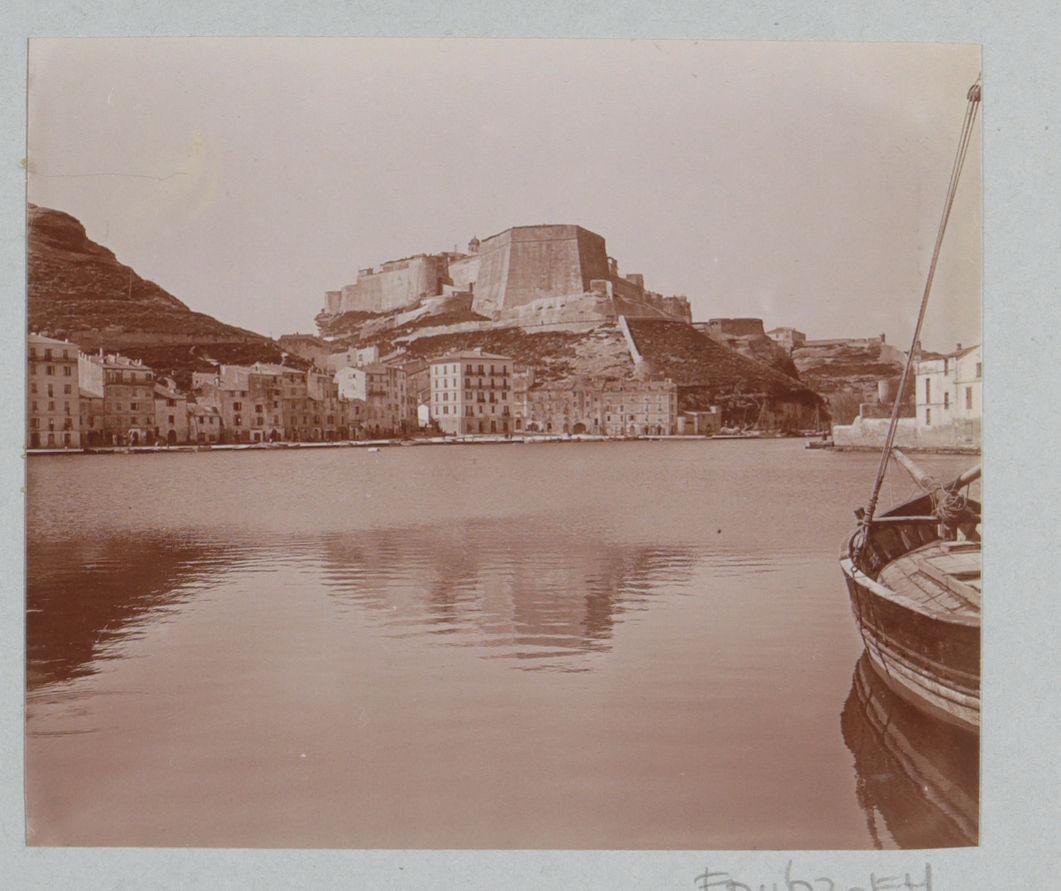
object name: photograph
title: Gezicht op Bonifacio op Corsica met haven en citadel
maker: Anonymous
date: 1905-1910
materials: paper, photographic support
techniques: gelatin silver print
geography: bonifacio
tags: harbour, fortified city, prospect of city, town panorama, silhouette of city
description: Onderdeel van Fotoalbum van een Franse amateurfotograaf met bezienswaardigheden in Frankrijk, Zwitserland en Italië.